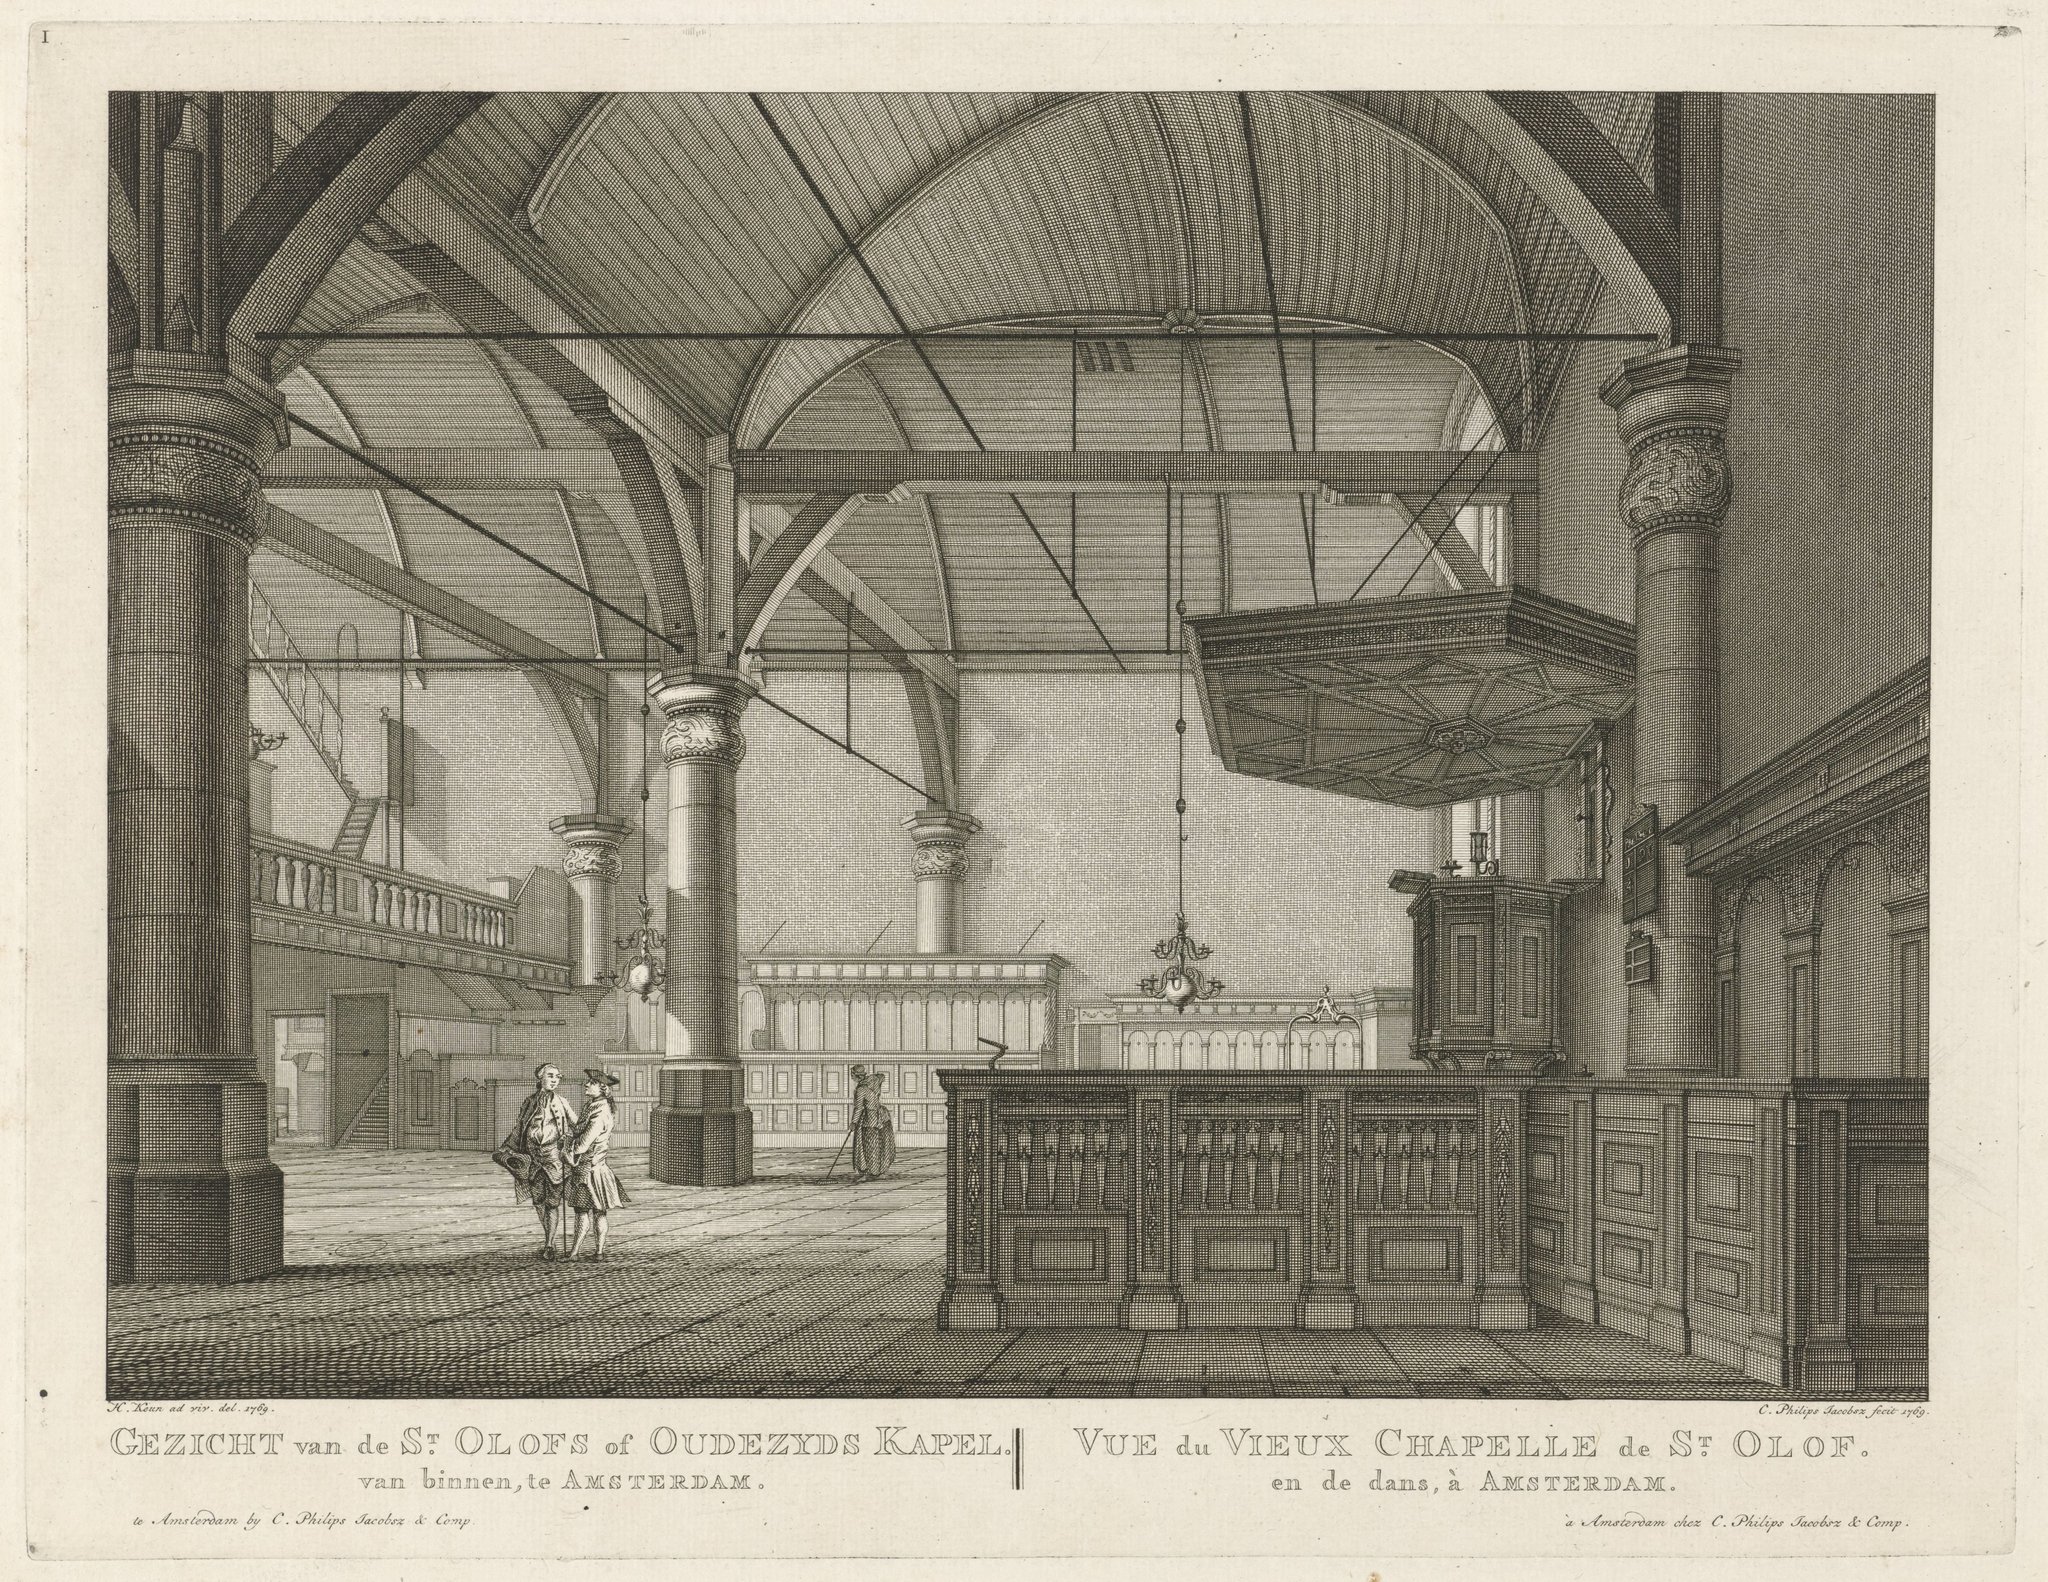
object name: print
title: Gezicht van de St. Olofs of Oudezyds Kapel van binnen, te Amsterdam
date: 1769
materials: paper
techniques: engraving, etching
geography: amsterdam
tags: interior of church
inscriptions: collector's mark: Lugt 2228